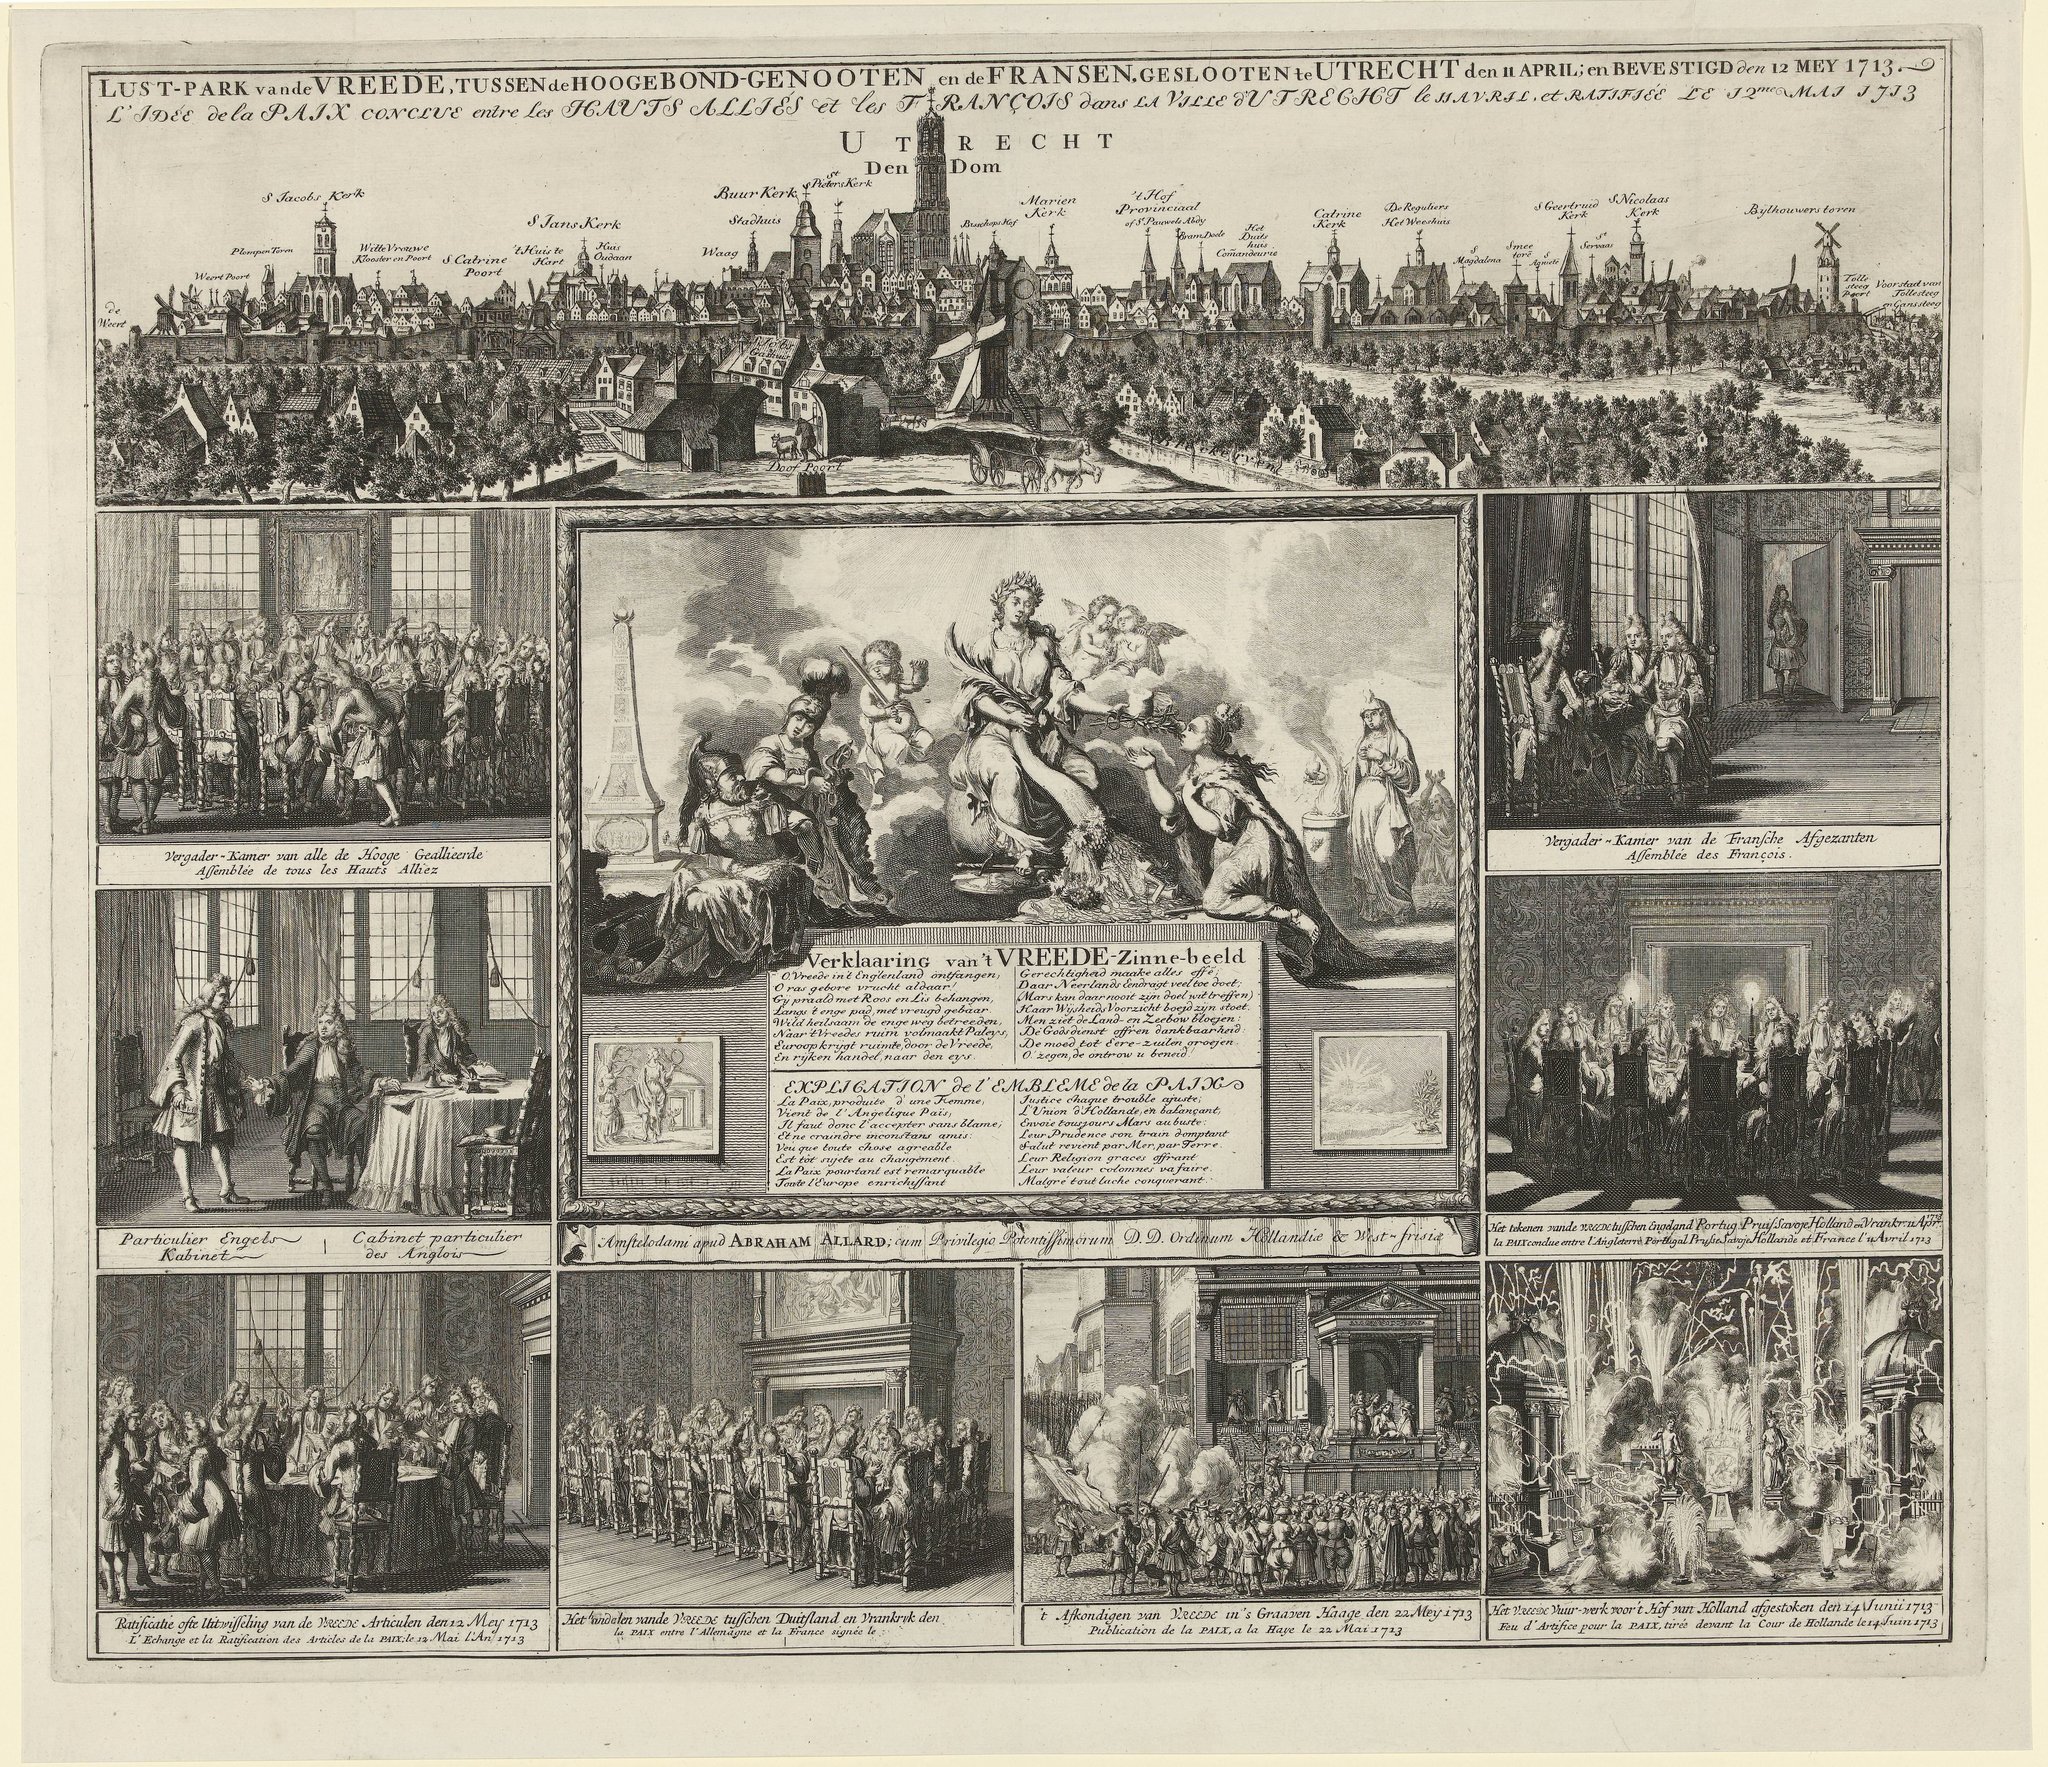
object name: print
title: L'Idée de la Paix conclue entre les Hauts Allies et les François dans la Ville d'Utrecht le 11 Avril, et Ratifiée le 12me Mai 1713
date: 1697-1699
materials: paper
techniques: engraving, etching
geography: amsterdam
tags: city-view in general; 'veduta', peace negotiations, proclamation of peace, festivities (+ illumination, fire-works ~ festive activities), utrecht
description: Deze plaat van Laurens Schem oorspronkelijk gebruikt voor de Vrede van Rijswijk in 1697 (FMH 2974).. Prent komt ook voor in: Les Principales Forteresses & Villes Fortes, d'Espagne, de France, d'Italie, de Savoië, d'Allemagne & des Païs-Bas ... / Naaukeurige Afbeeldingen der Voornaamste Sterke Steden en Vestingen in Spanjen, Vrankryk, Italien, Savoyen, Duytsland en Nederlanden ... Leidem: Pieter van der Aa, 1713.